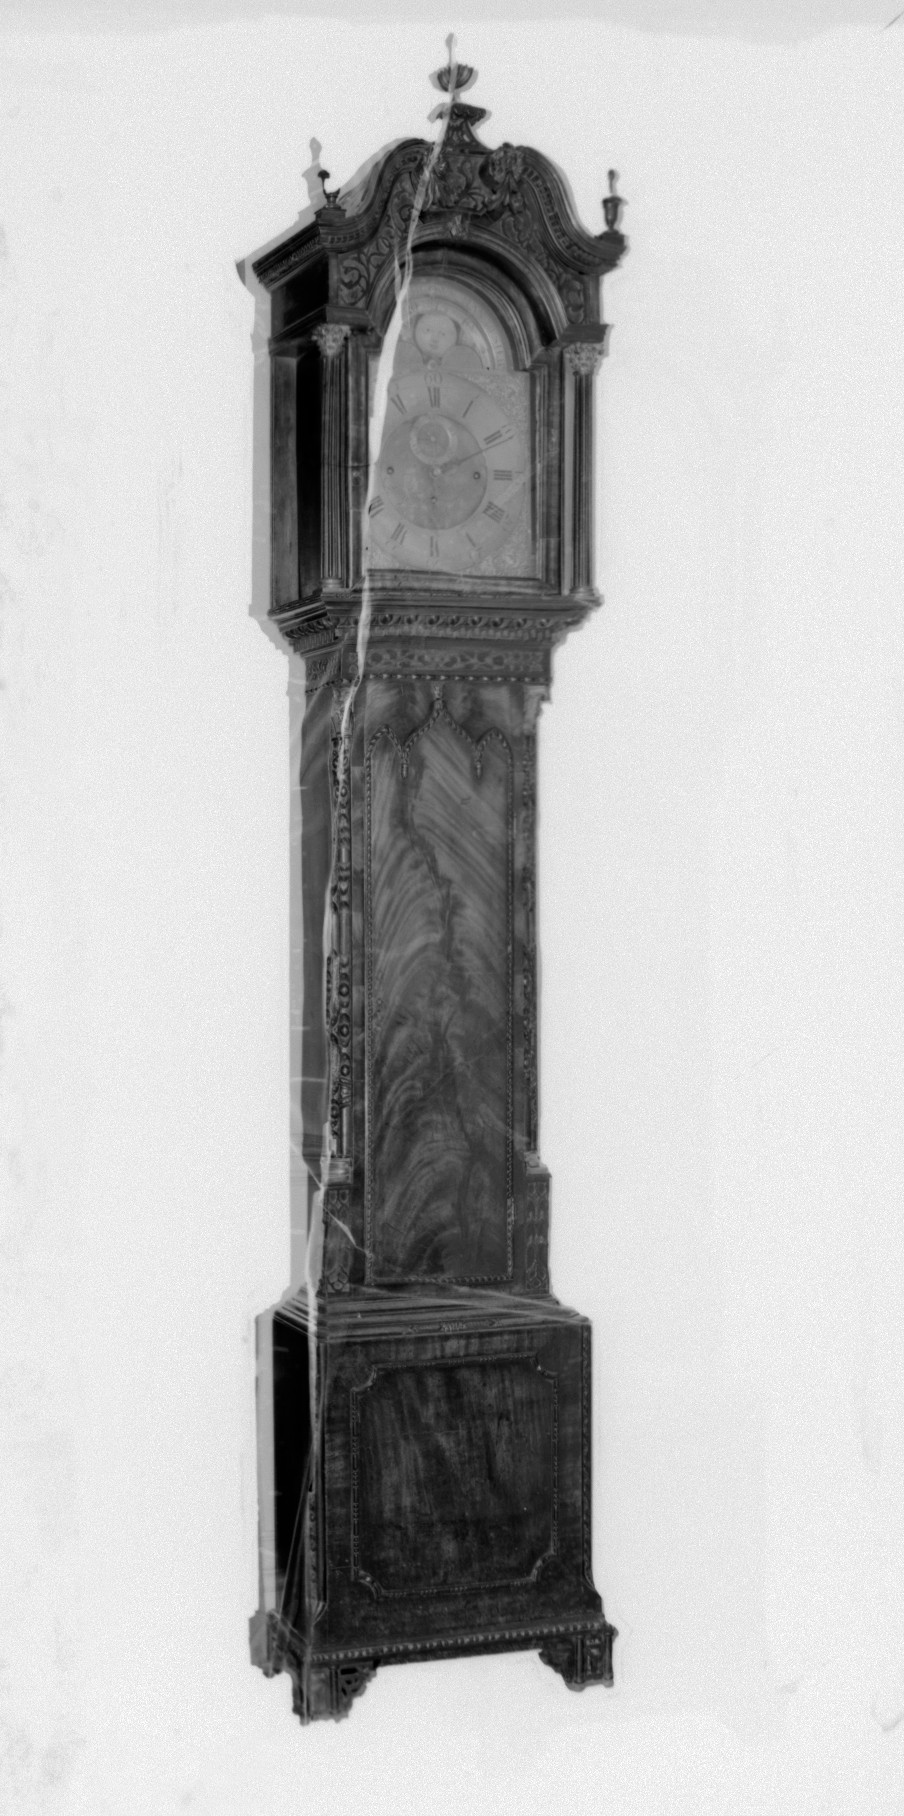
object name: longcase clock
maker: nathaniel brown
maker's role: maker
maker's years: 1725-1825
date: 1775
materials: wood